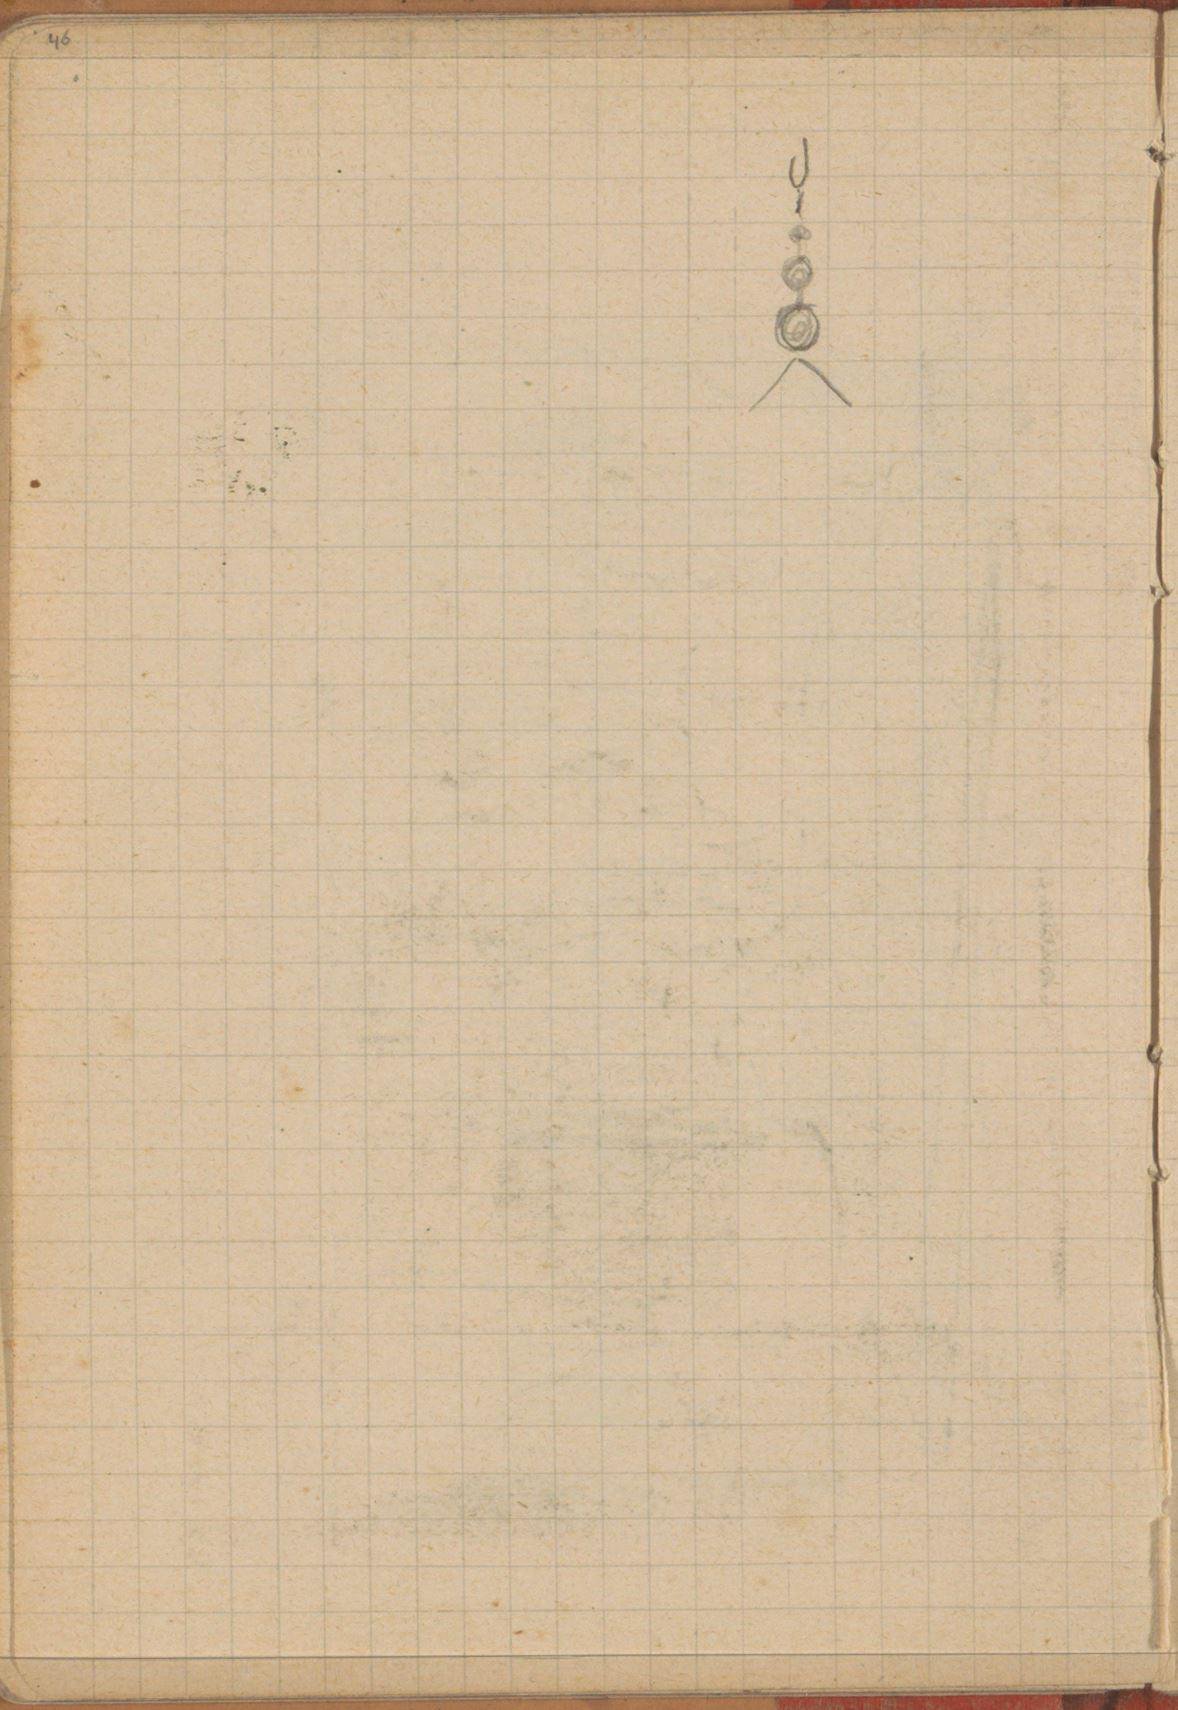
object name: sketchbook leaf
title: Torenspits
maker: marius bauer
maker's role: draughtsman, print maker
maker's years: 1867-1932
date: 1909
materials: pencil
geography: tunis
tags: spire (of tower on house or building)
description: Vermoedelijk de torenspits van een moskee. Pagina 46 uit een schetsboek met 67 bladen.